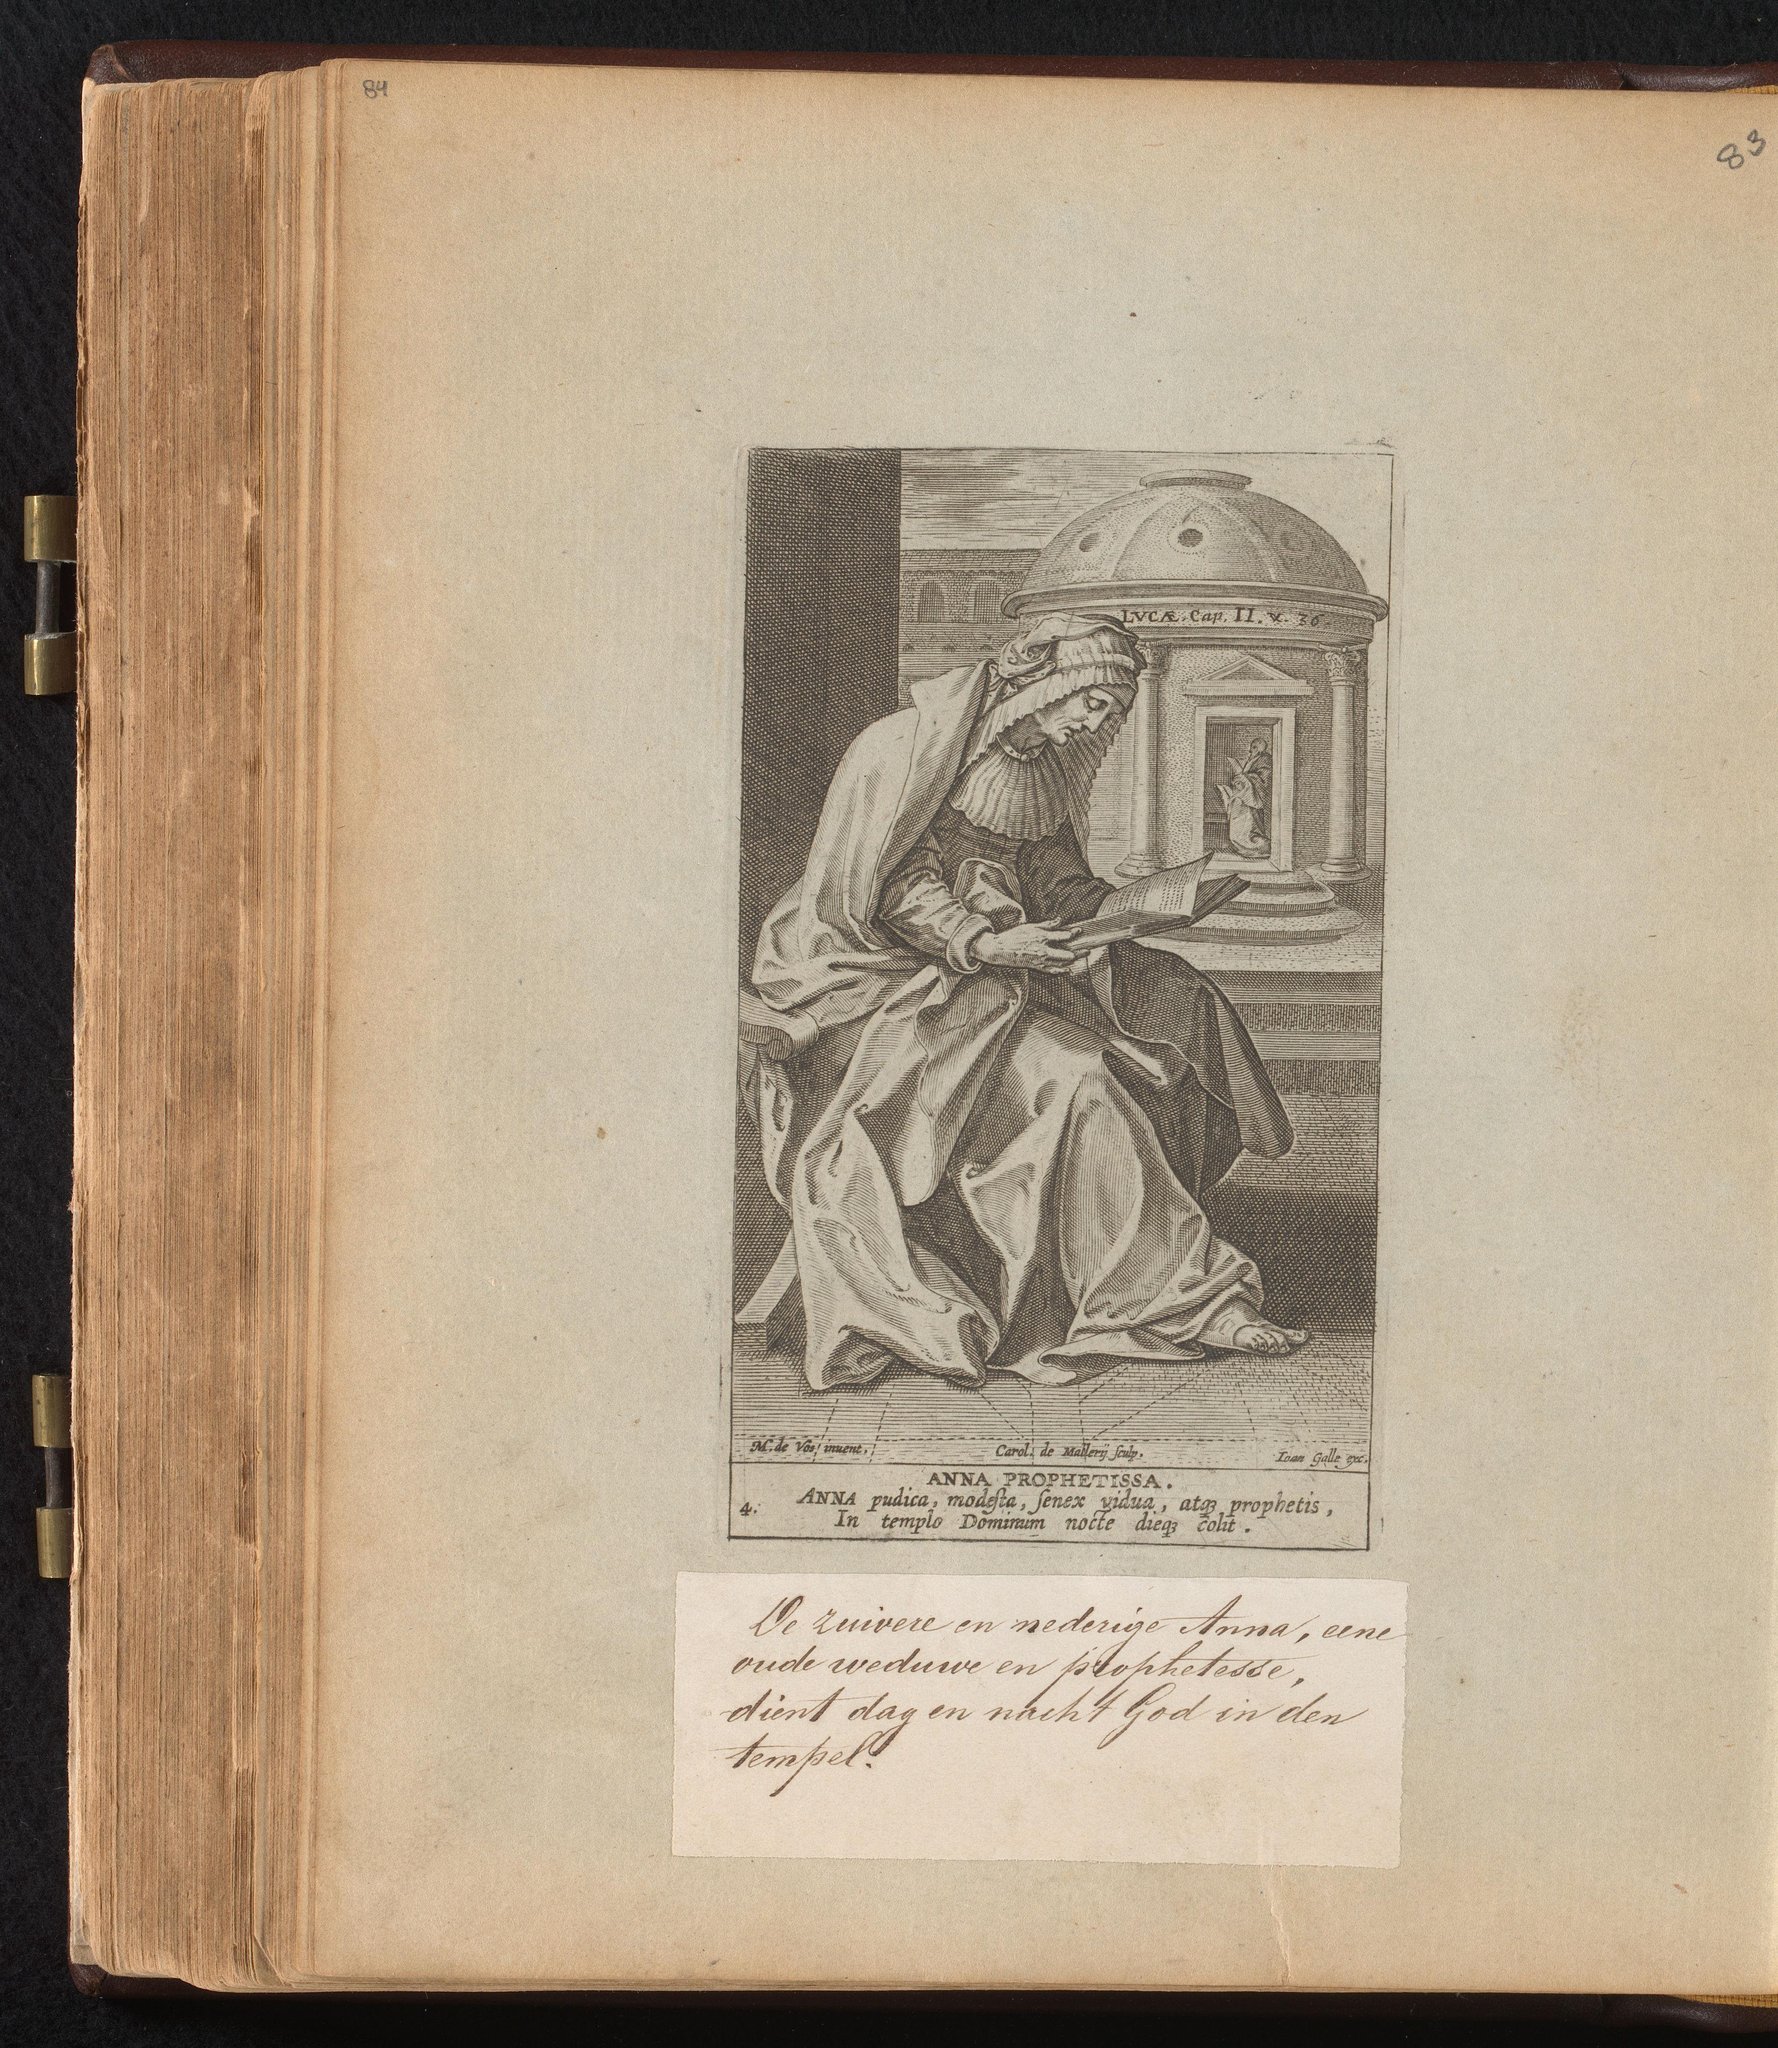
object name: album leaf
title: Icones Illvstrivm Feminarvm Novi Testamenti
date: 1599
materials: paper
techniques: engraving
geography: antwerp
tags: anna prophesying ~ presentation of the christ-child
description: Prent maakt deel uit van een prentbijbel.